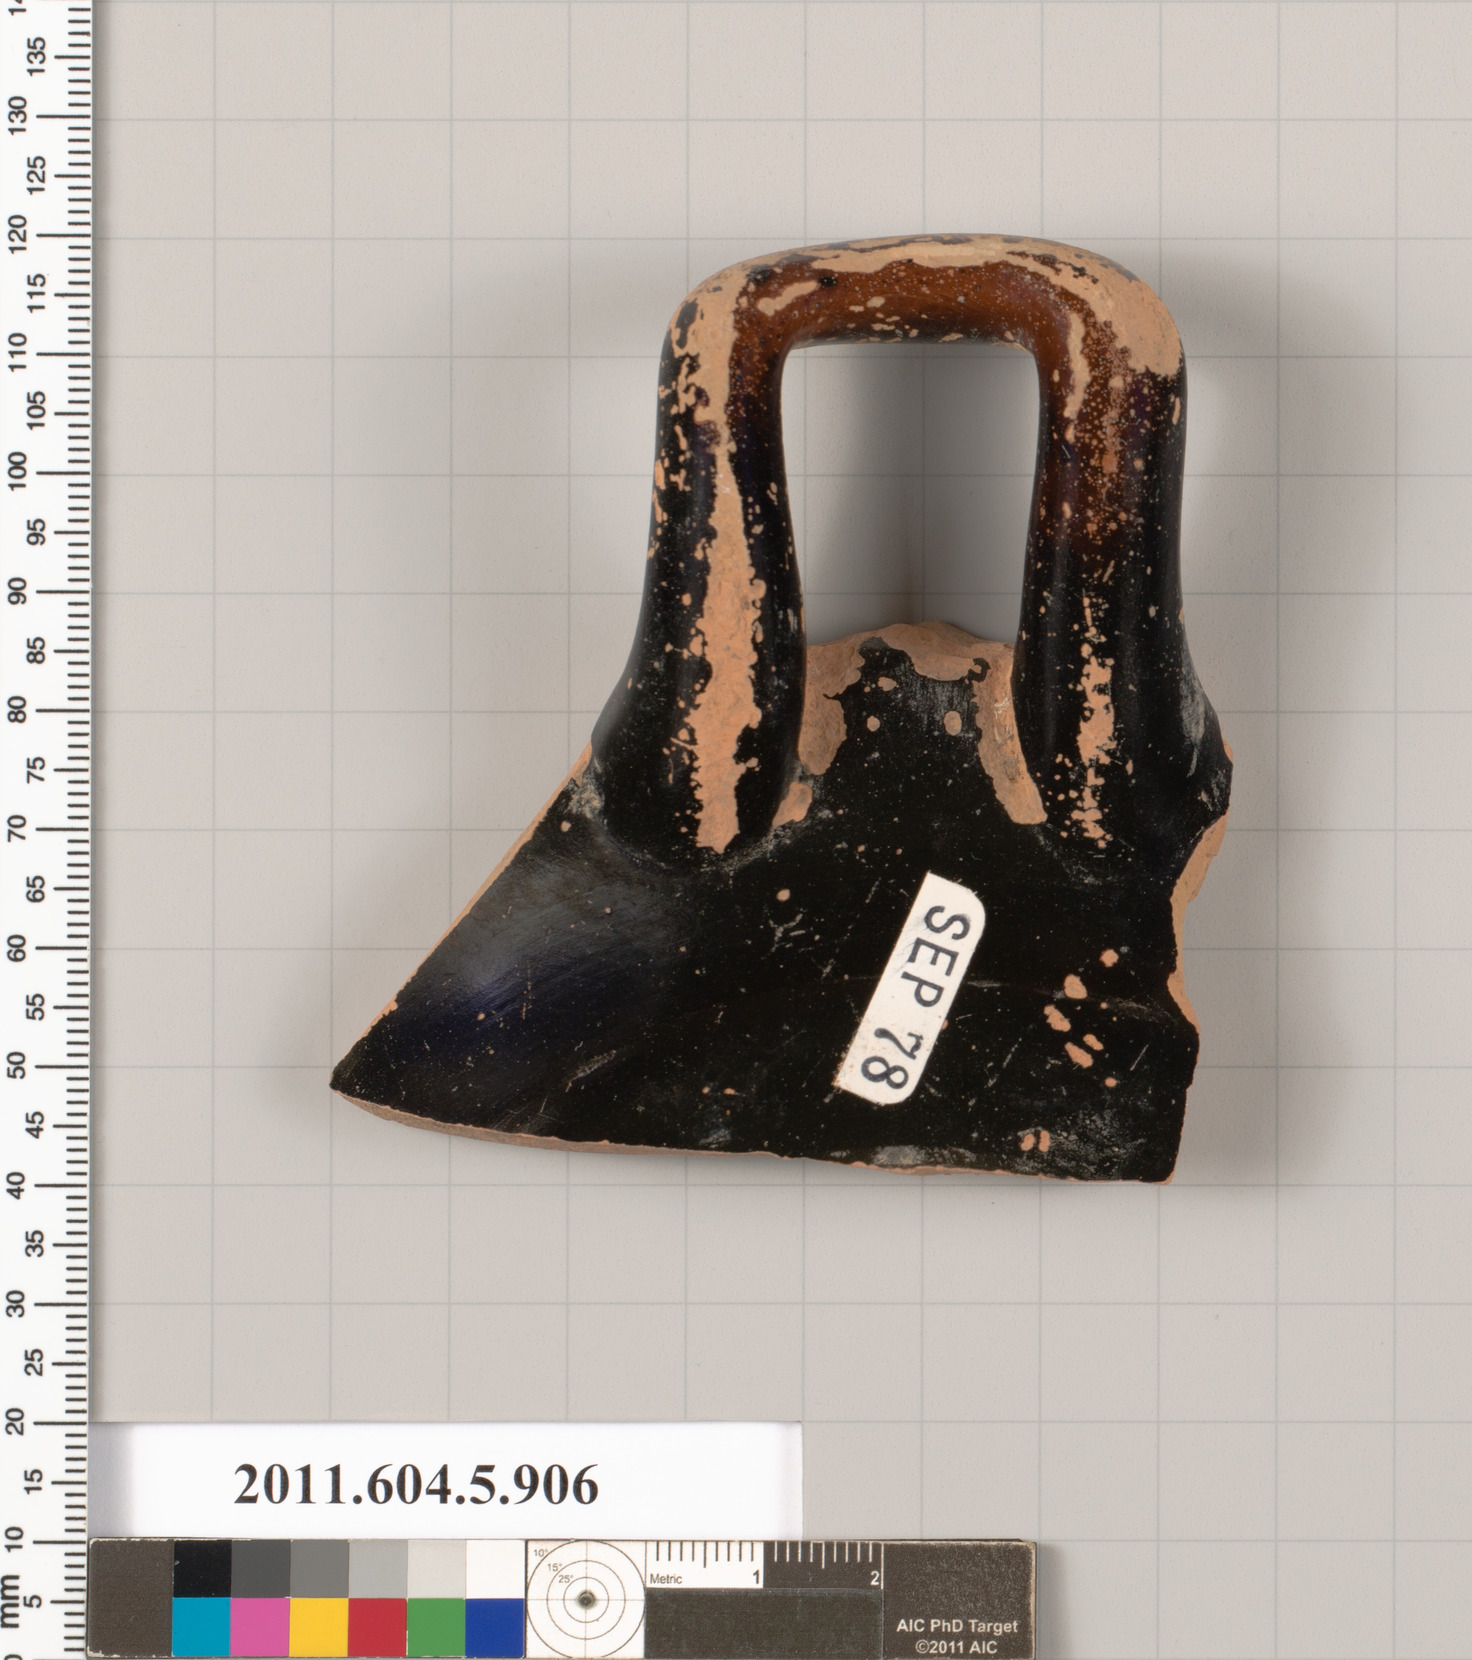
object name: kylix fragment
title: Terracotta fragment of a kylix (drinking cup)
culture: greek, attic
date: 600-401 BCE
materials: terracotta